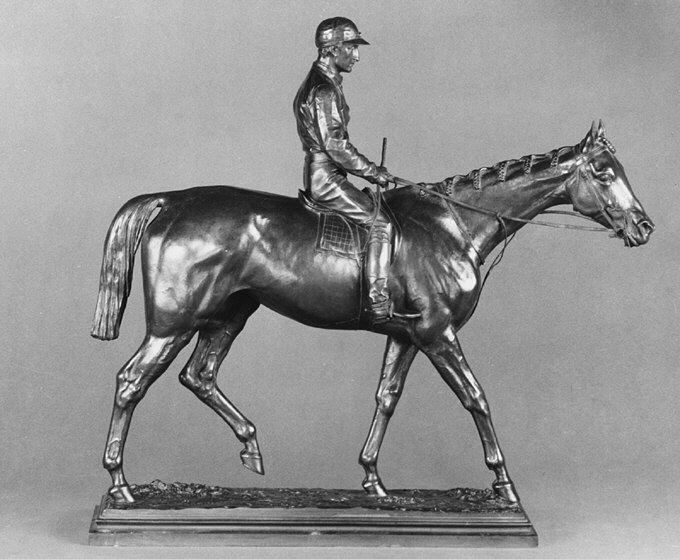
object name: statuette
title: Jockey on a Horse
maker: isidore bonheur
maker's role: artist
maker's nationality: french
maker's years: 1827-1901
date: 1877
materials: bronze, marble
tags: horses,jockeys